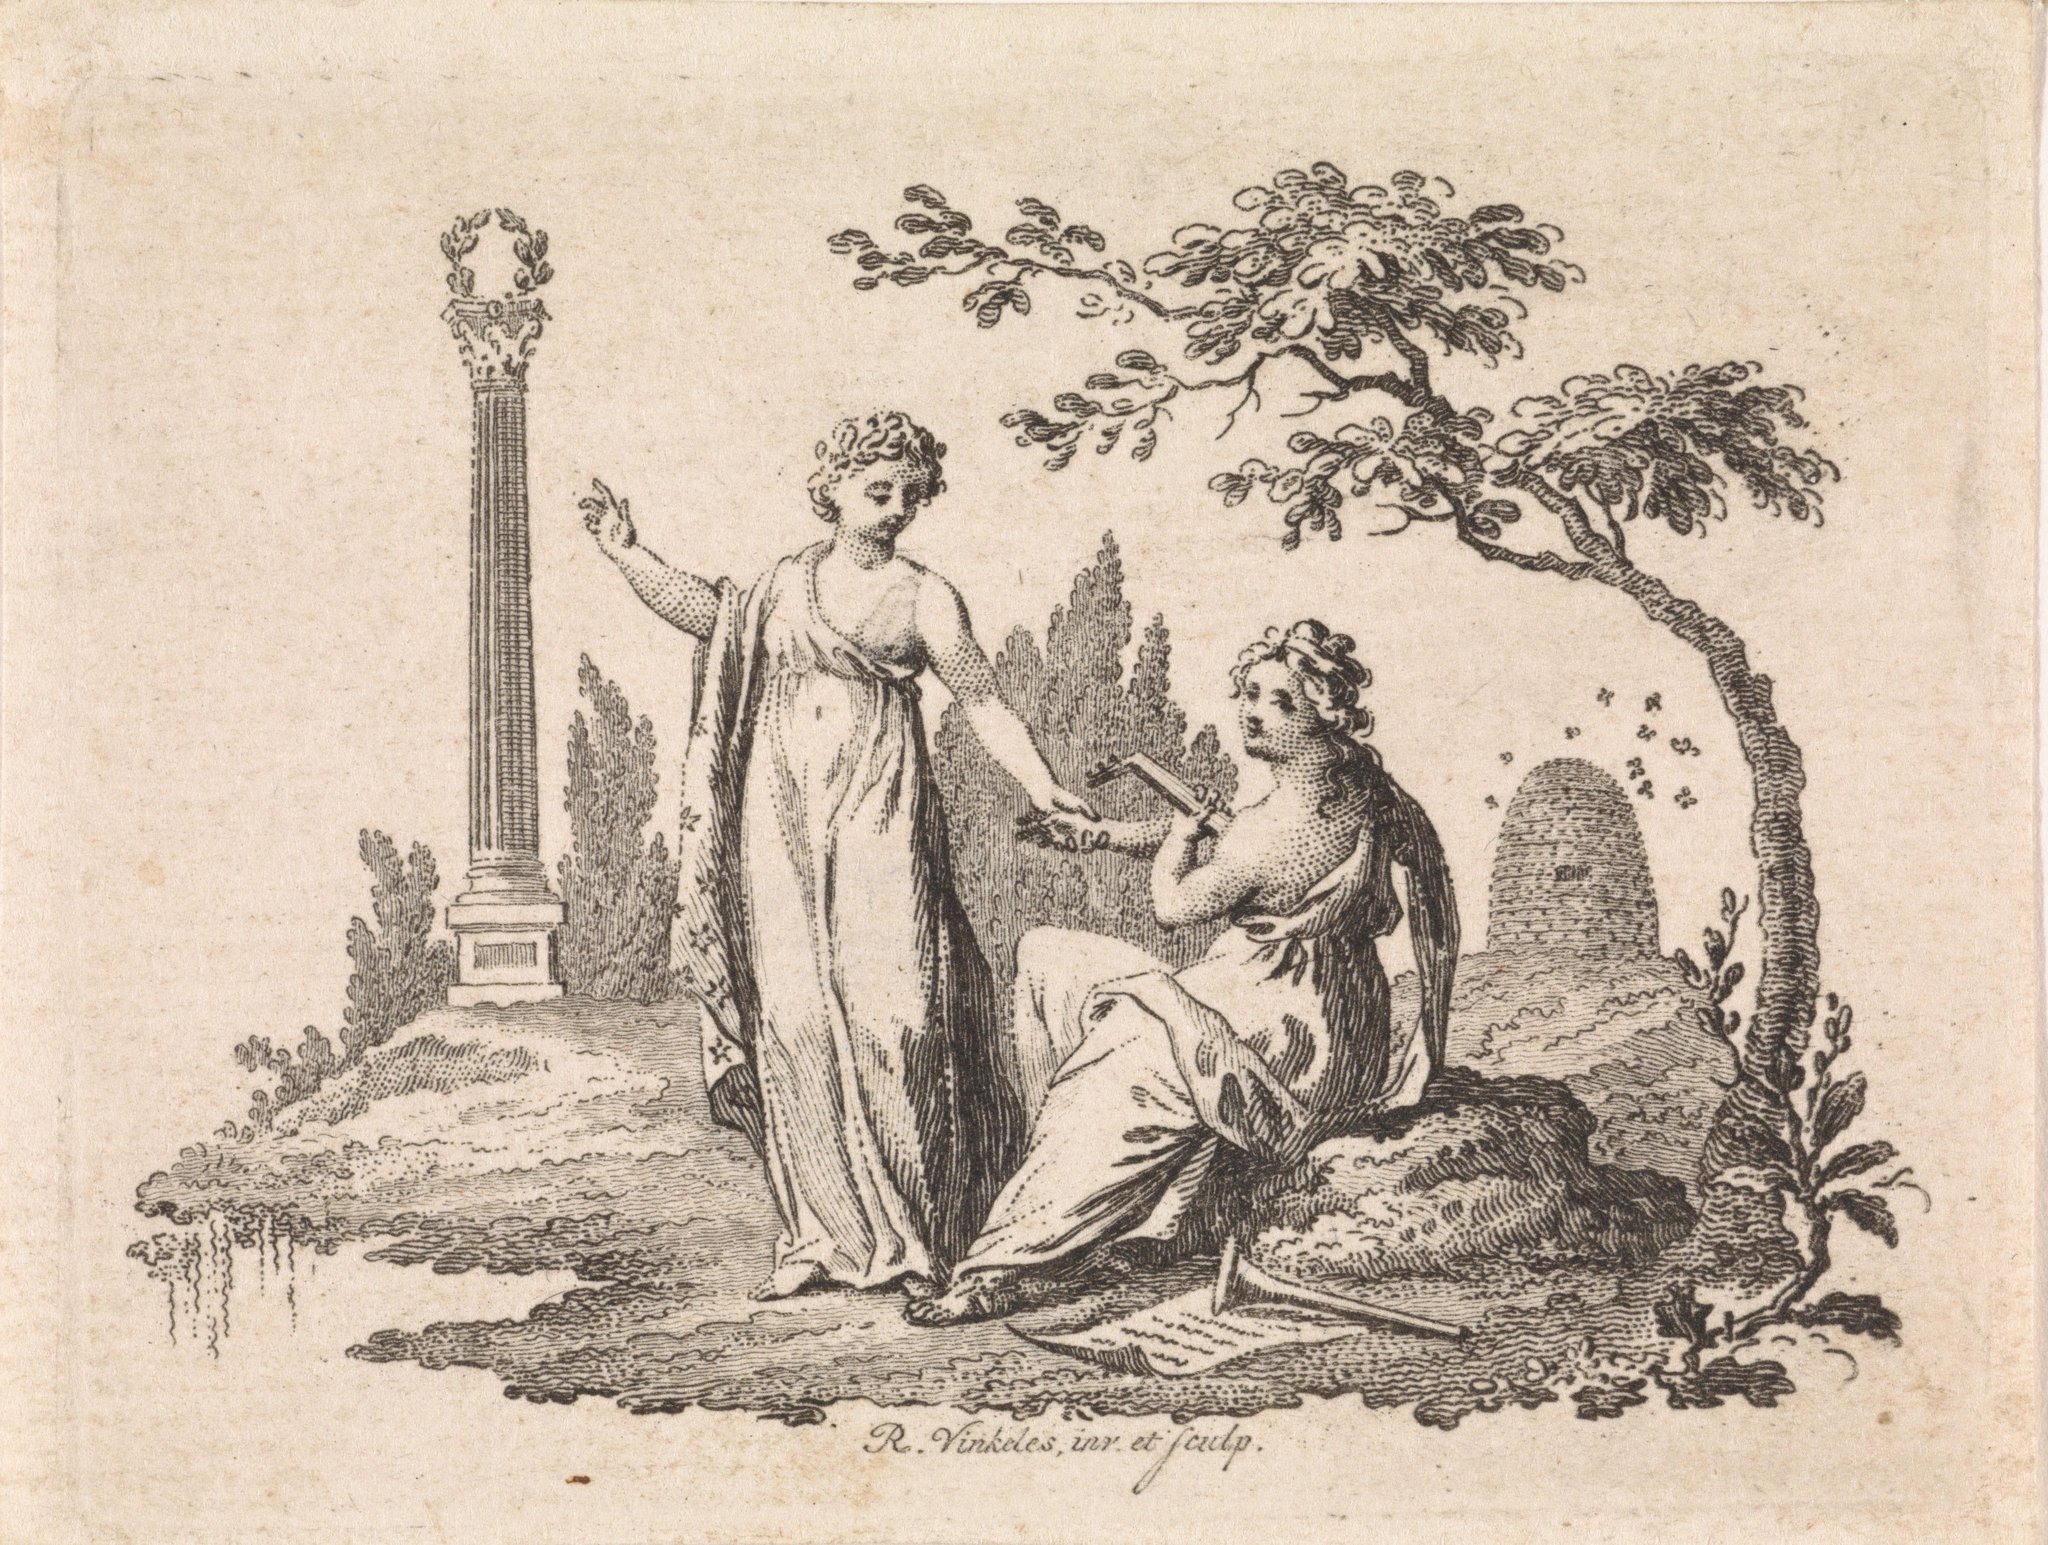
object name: print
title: Landschap met een luitspelende vrouw en een vrouw die naar een klassieke zuil wijst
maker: reinier vinkeles (i)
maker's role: draughtsman, print maker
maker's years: 1741-1816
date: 1751-1816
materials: paper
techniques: engraving, etching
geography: amsterdam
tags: tuning the lute - cc - out of doors, column, pillar ~ architecture, bee-hive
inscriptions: collector's mark: Lugt 2228